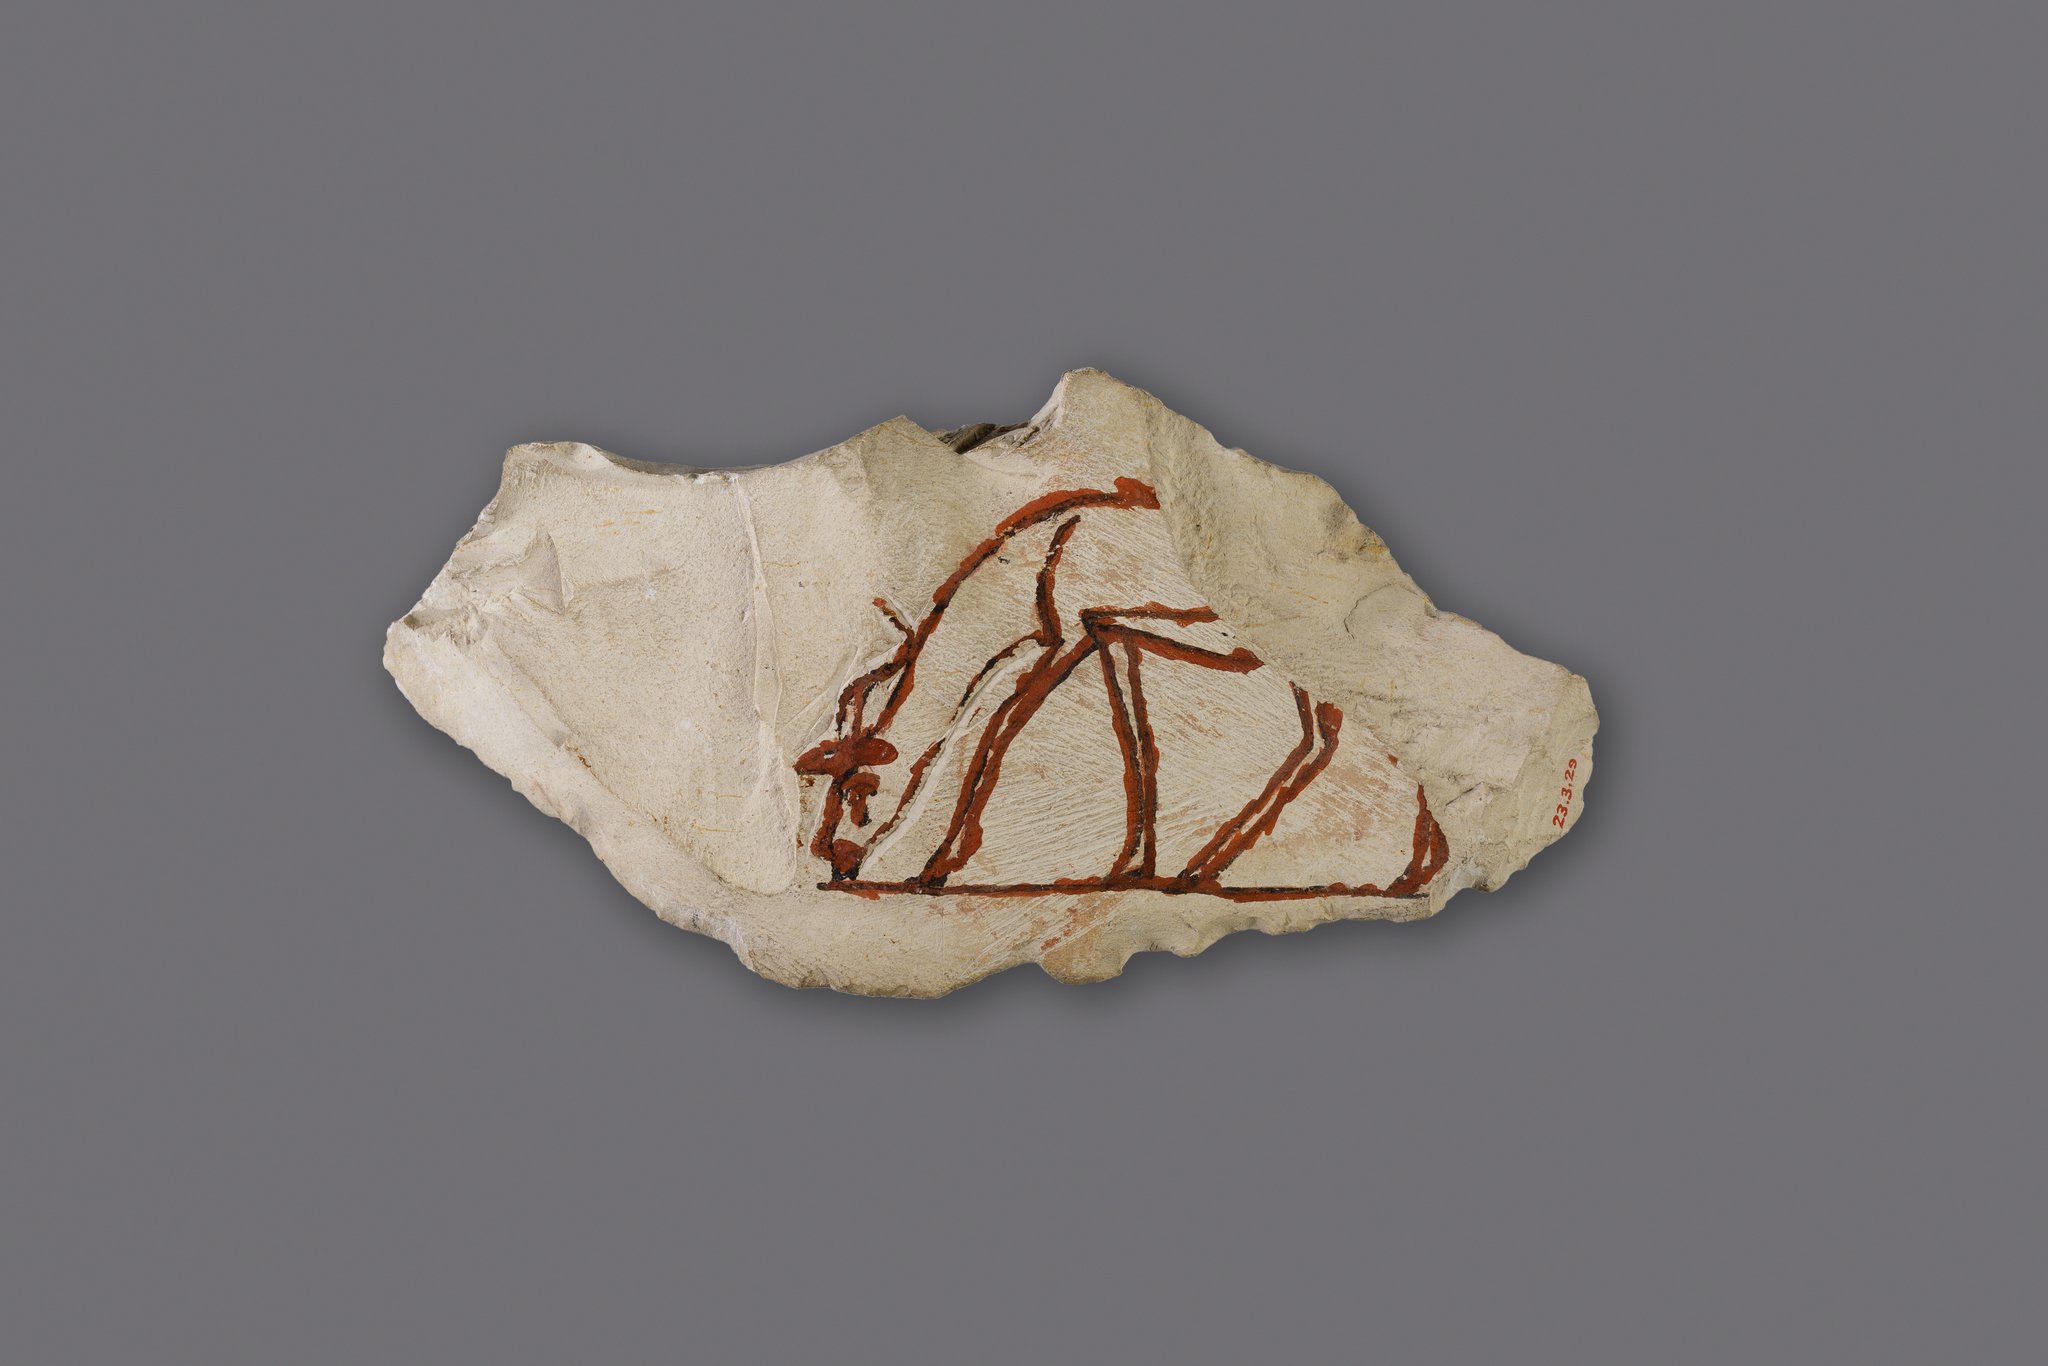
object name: ostracon, figured, antelope grazing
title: Ostracon with sketch of a grazing antelope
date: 664-610 BCE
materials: ink, limestone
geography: egypt